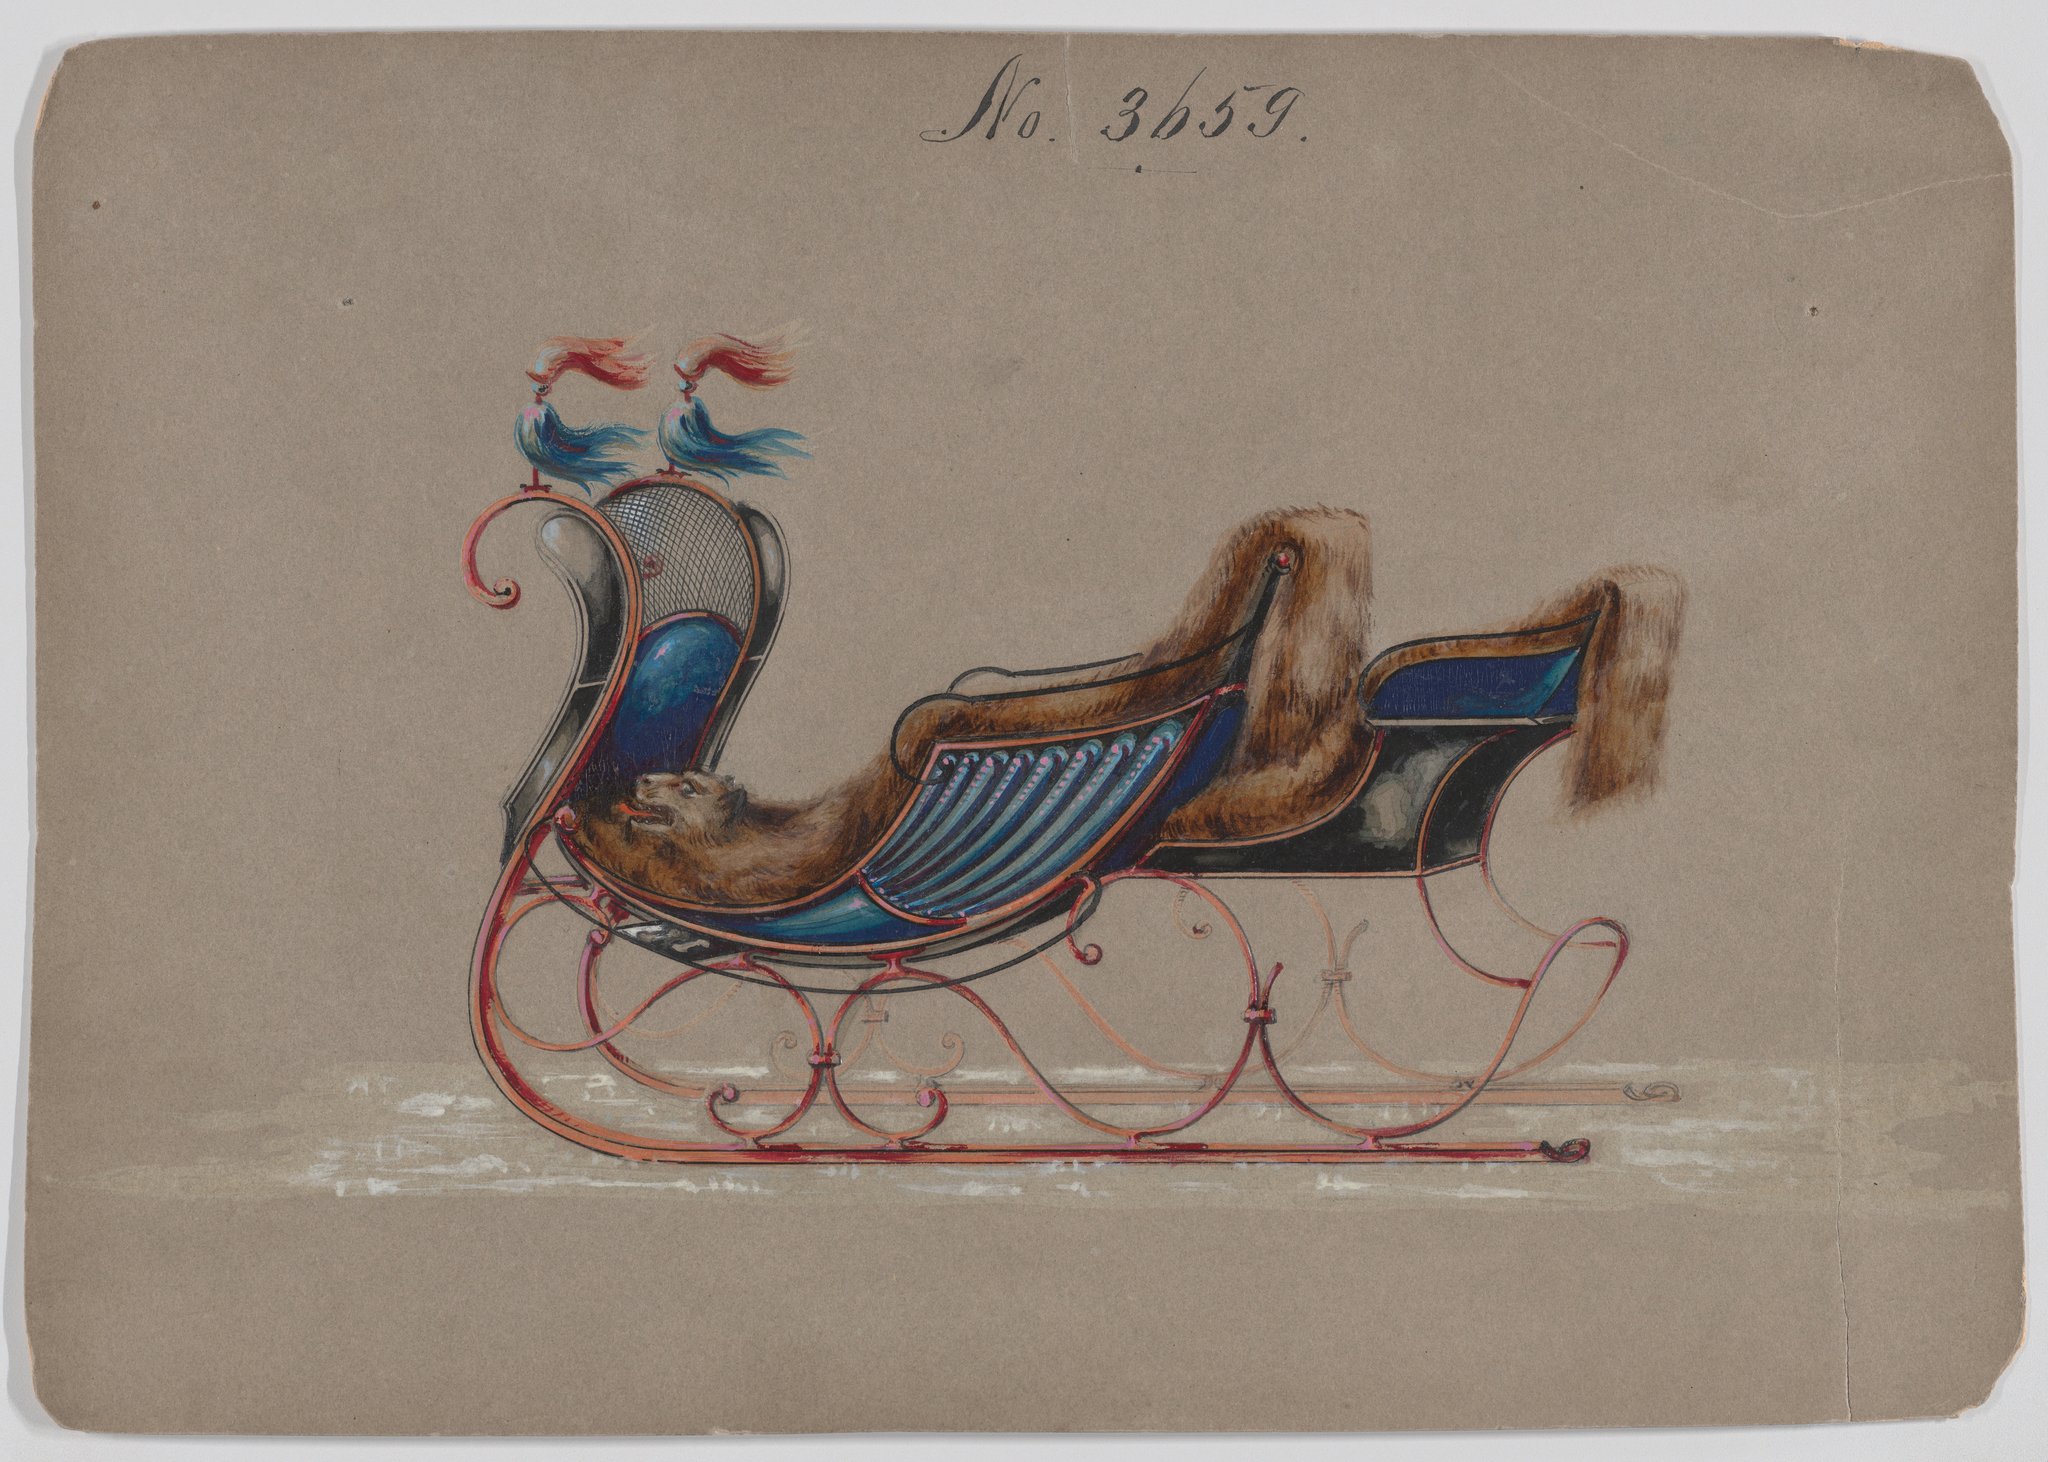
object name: drawing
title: Sleigh #3659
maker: brewster & co.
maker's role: manufacturer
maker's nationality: american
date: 1881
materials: gouache, gum arabic, ink, watercolor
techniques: pen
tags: sleighs